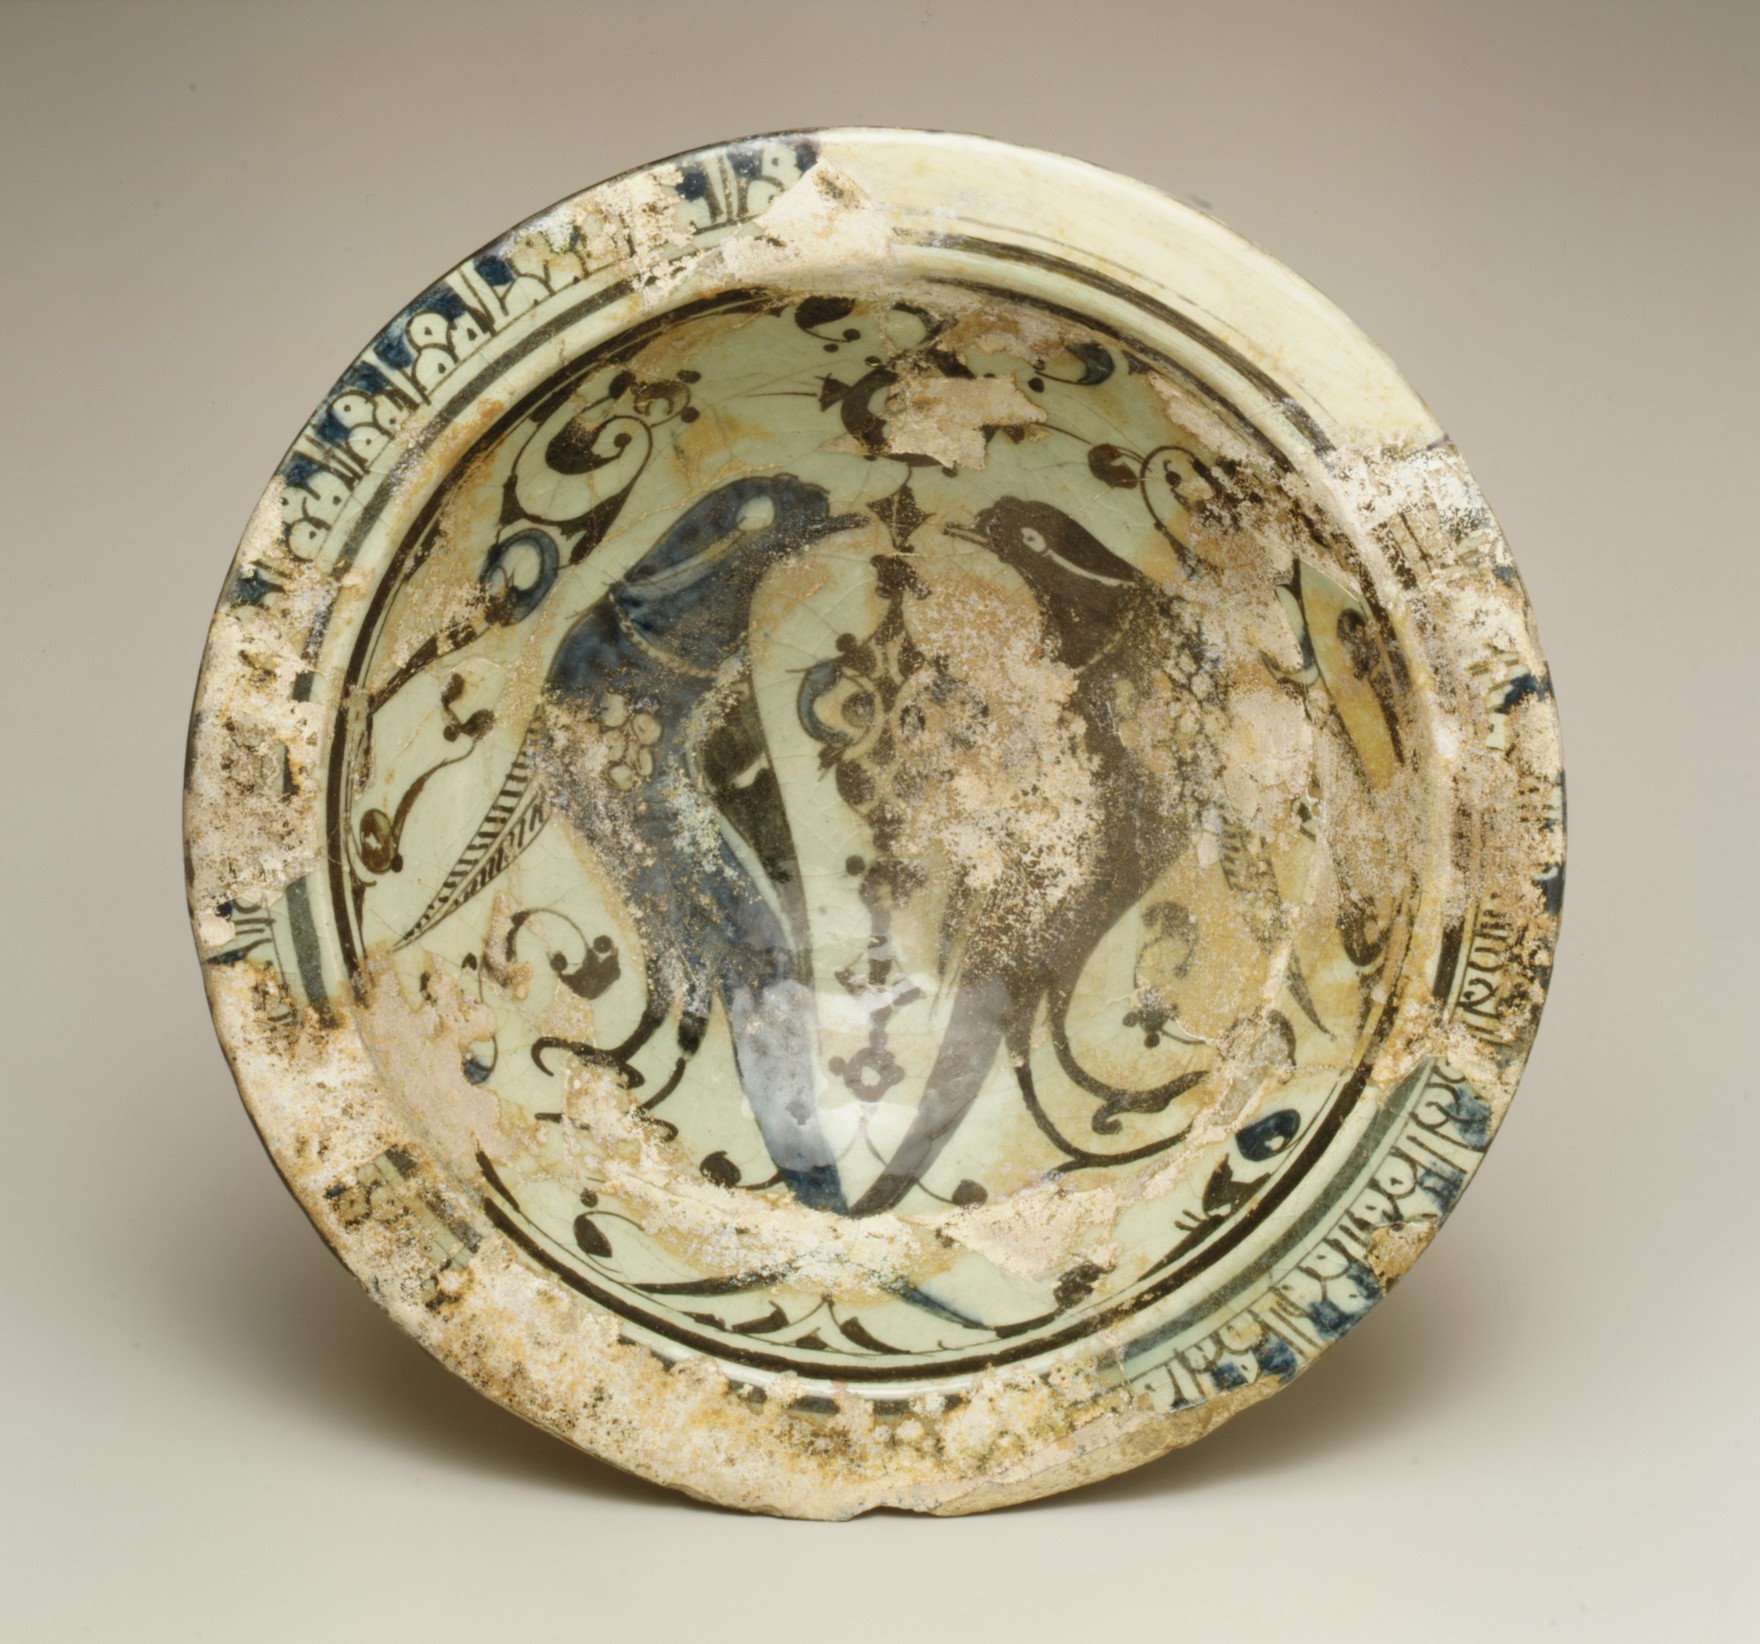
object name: bowl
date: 1101-1200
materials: stonepaste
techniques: painting, underglaze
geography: syria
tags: birds